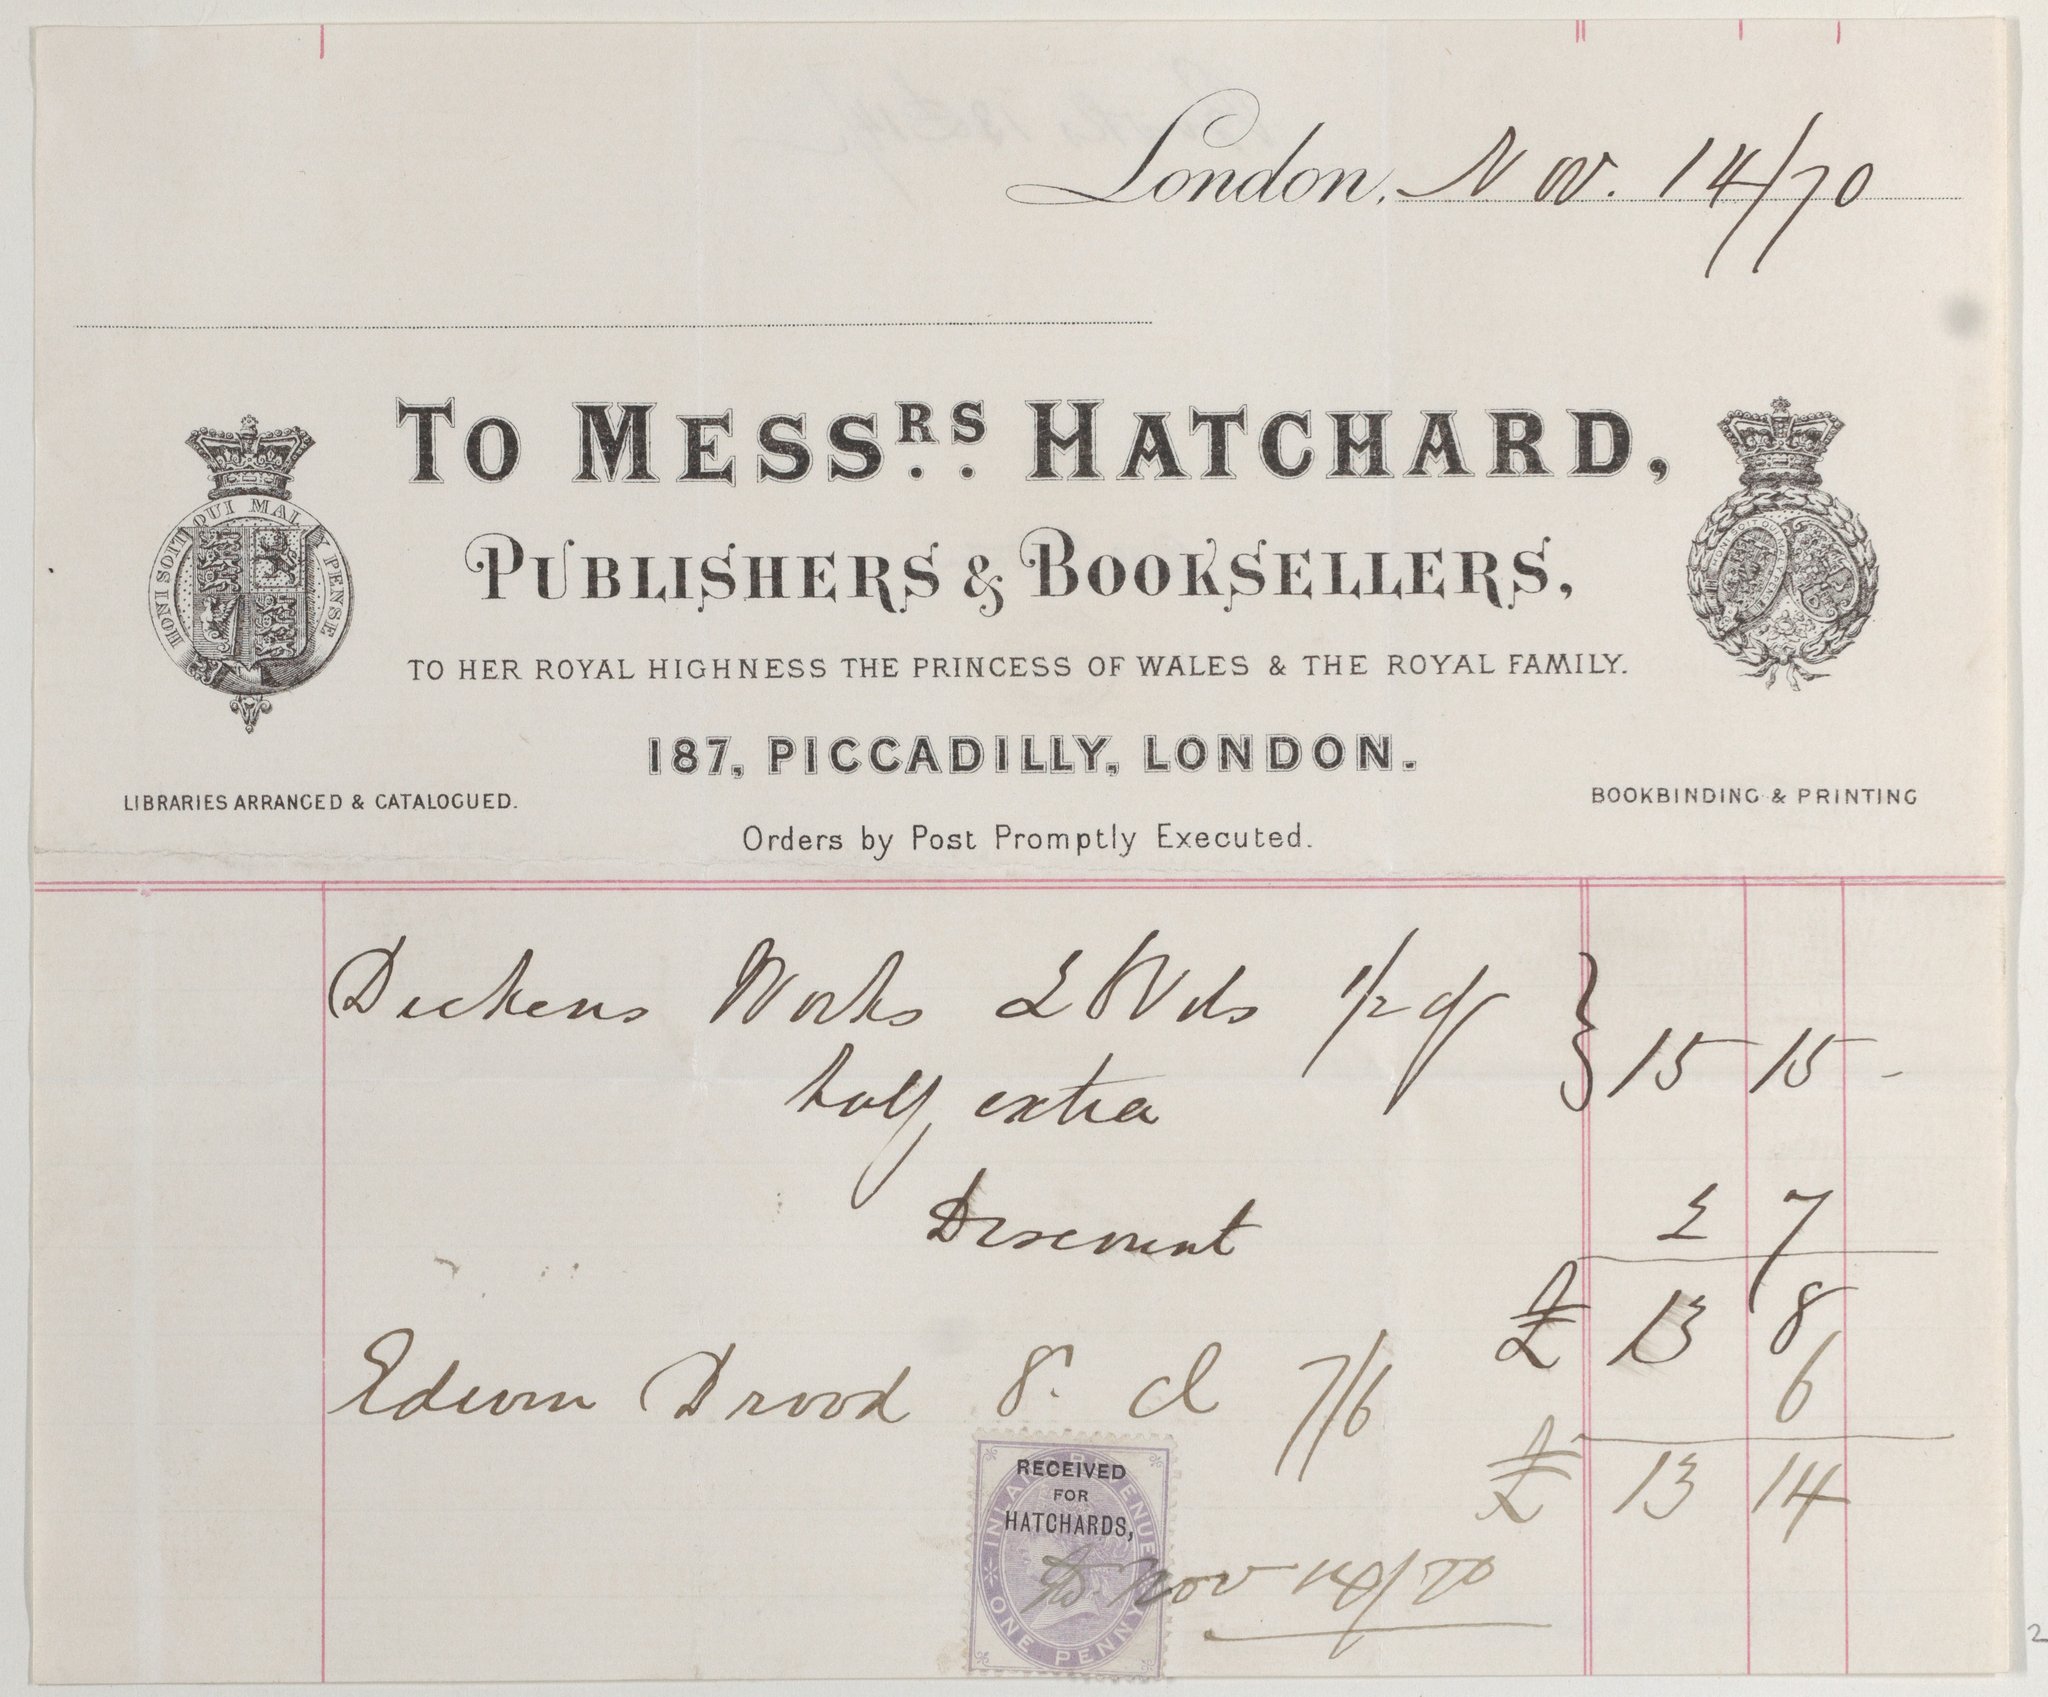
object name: print, trade card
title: Trade card for Messrs. Hatchard, publishers and booksellers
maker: anonymous, british, 19th century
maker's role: artist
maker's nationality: british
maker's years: 1800-1900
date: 1801-1900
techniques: lithography